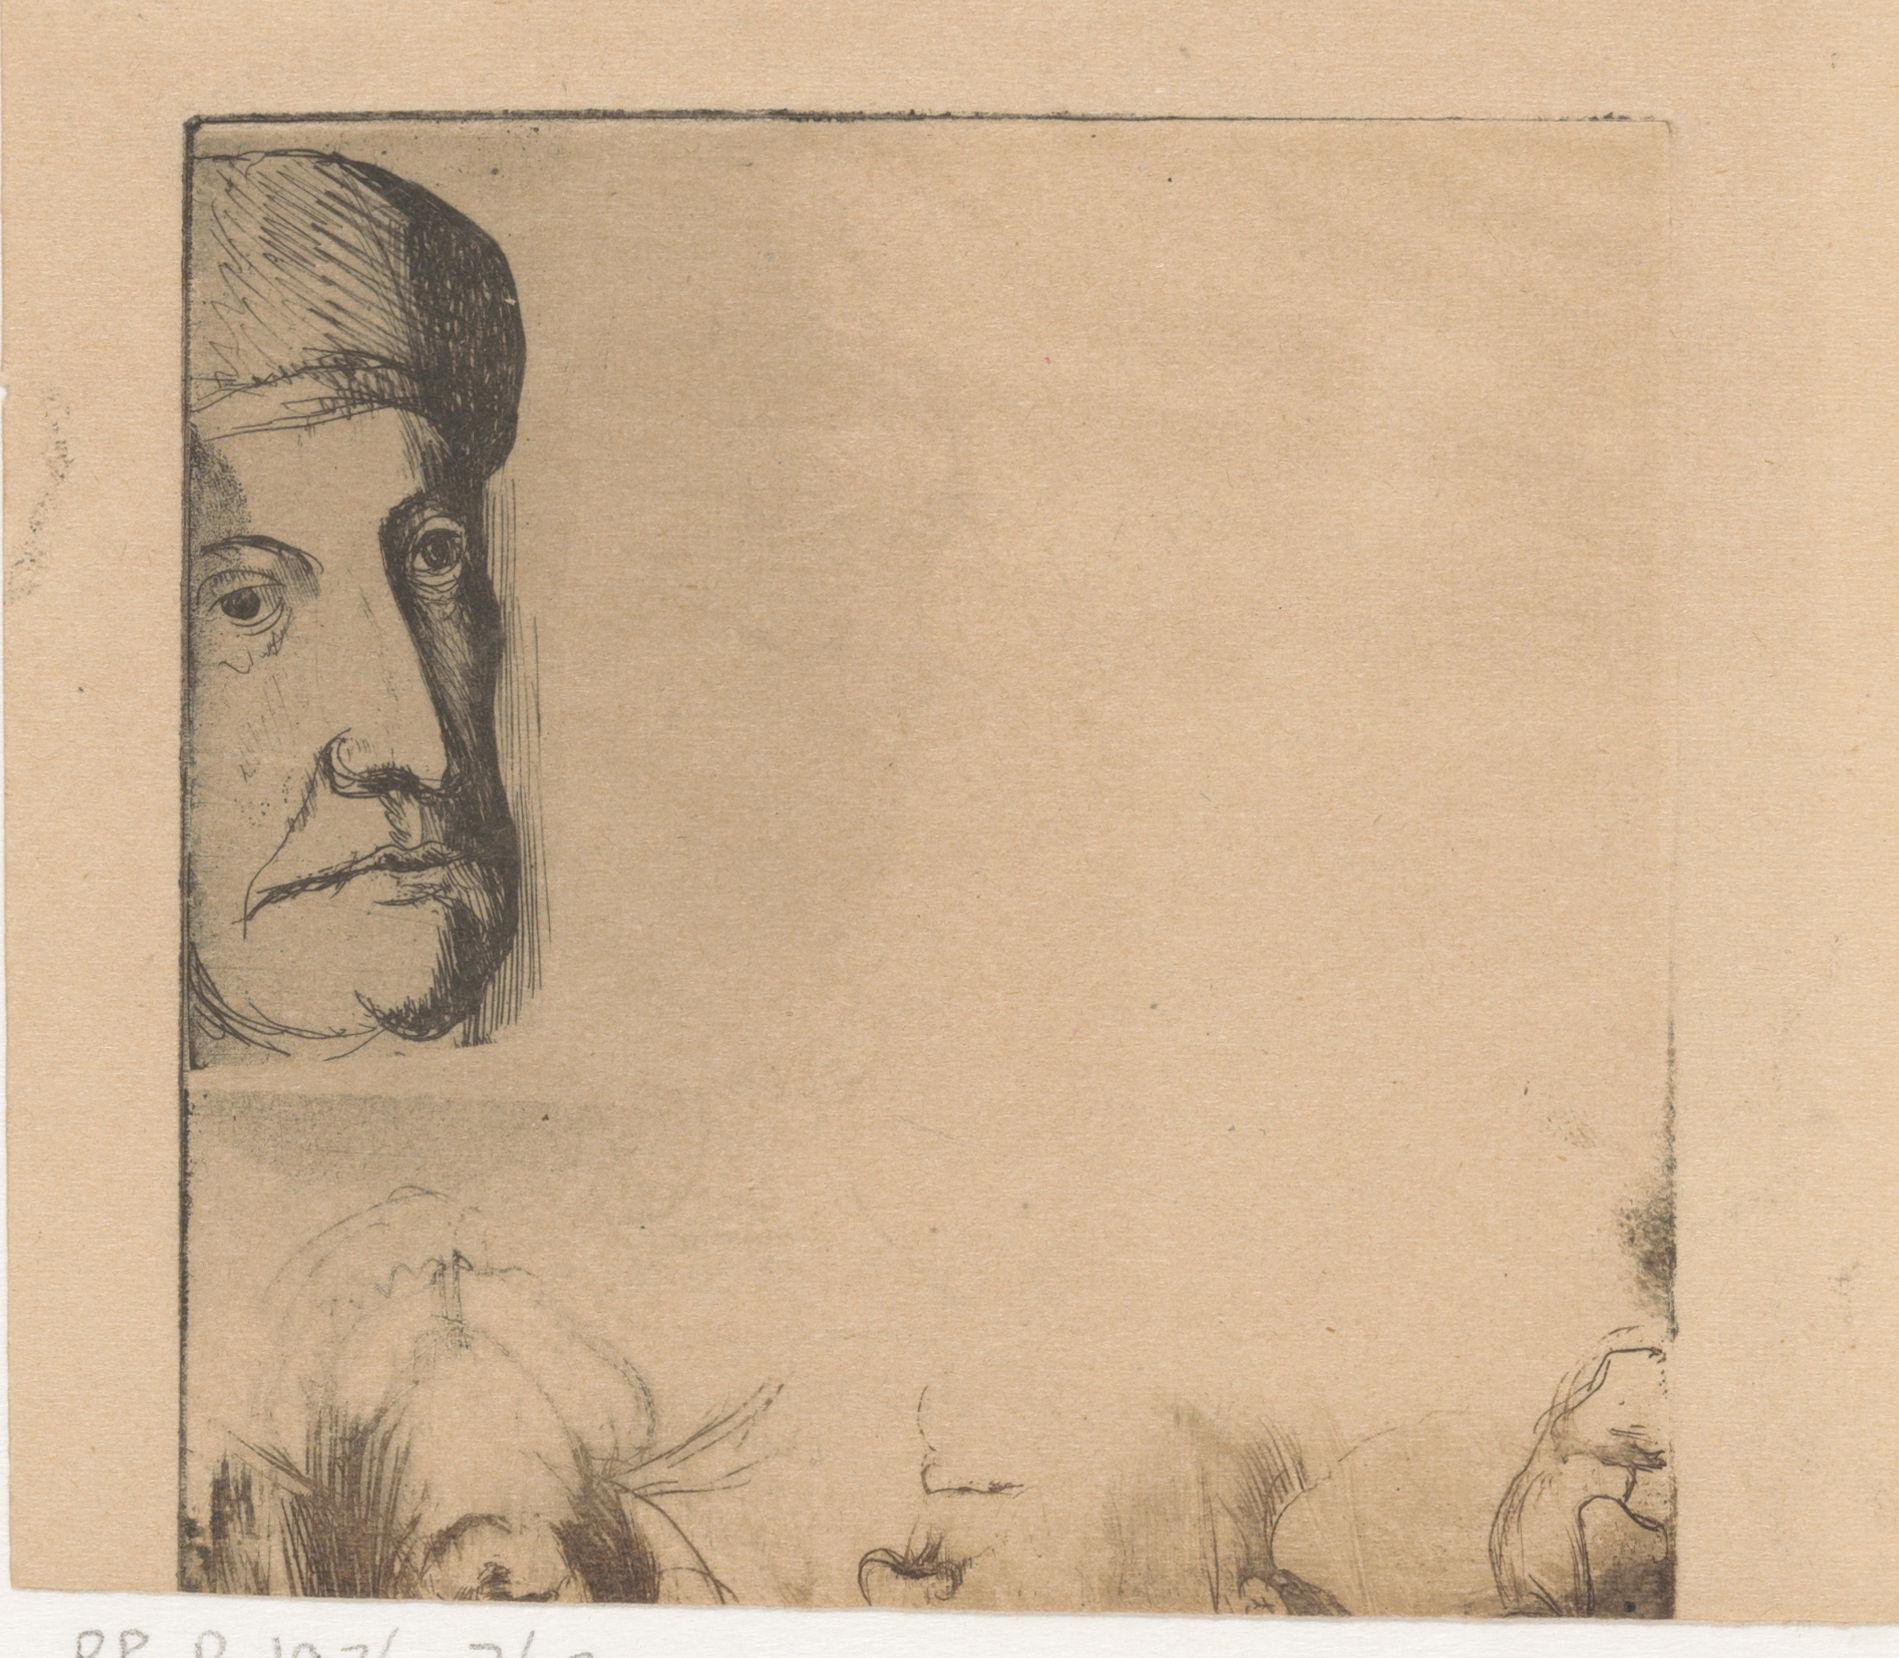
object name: print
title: Studie van een mannenhoofd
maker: marius holleman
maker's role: draughtsman, print maker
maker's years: 1878-1926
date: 1904-1926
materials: paper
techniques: etching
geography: groningen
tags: adult man, head-gear: hat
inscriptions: collector's mark: Lugt 2228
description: De man draagt een muts. Onderaan het blad halve gezichten van drie figuren.